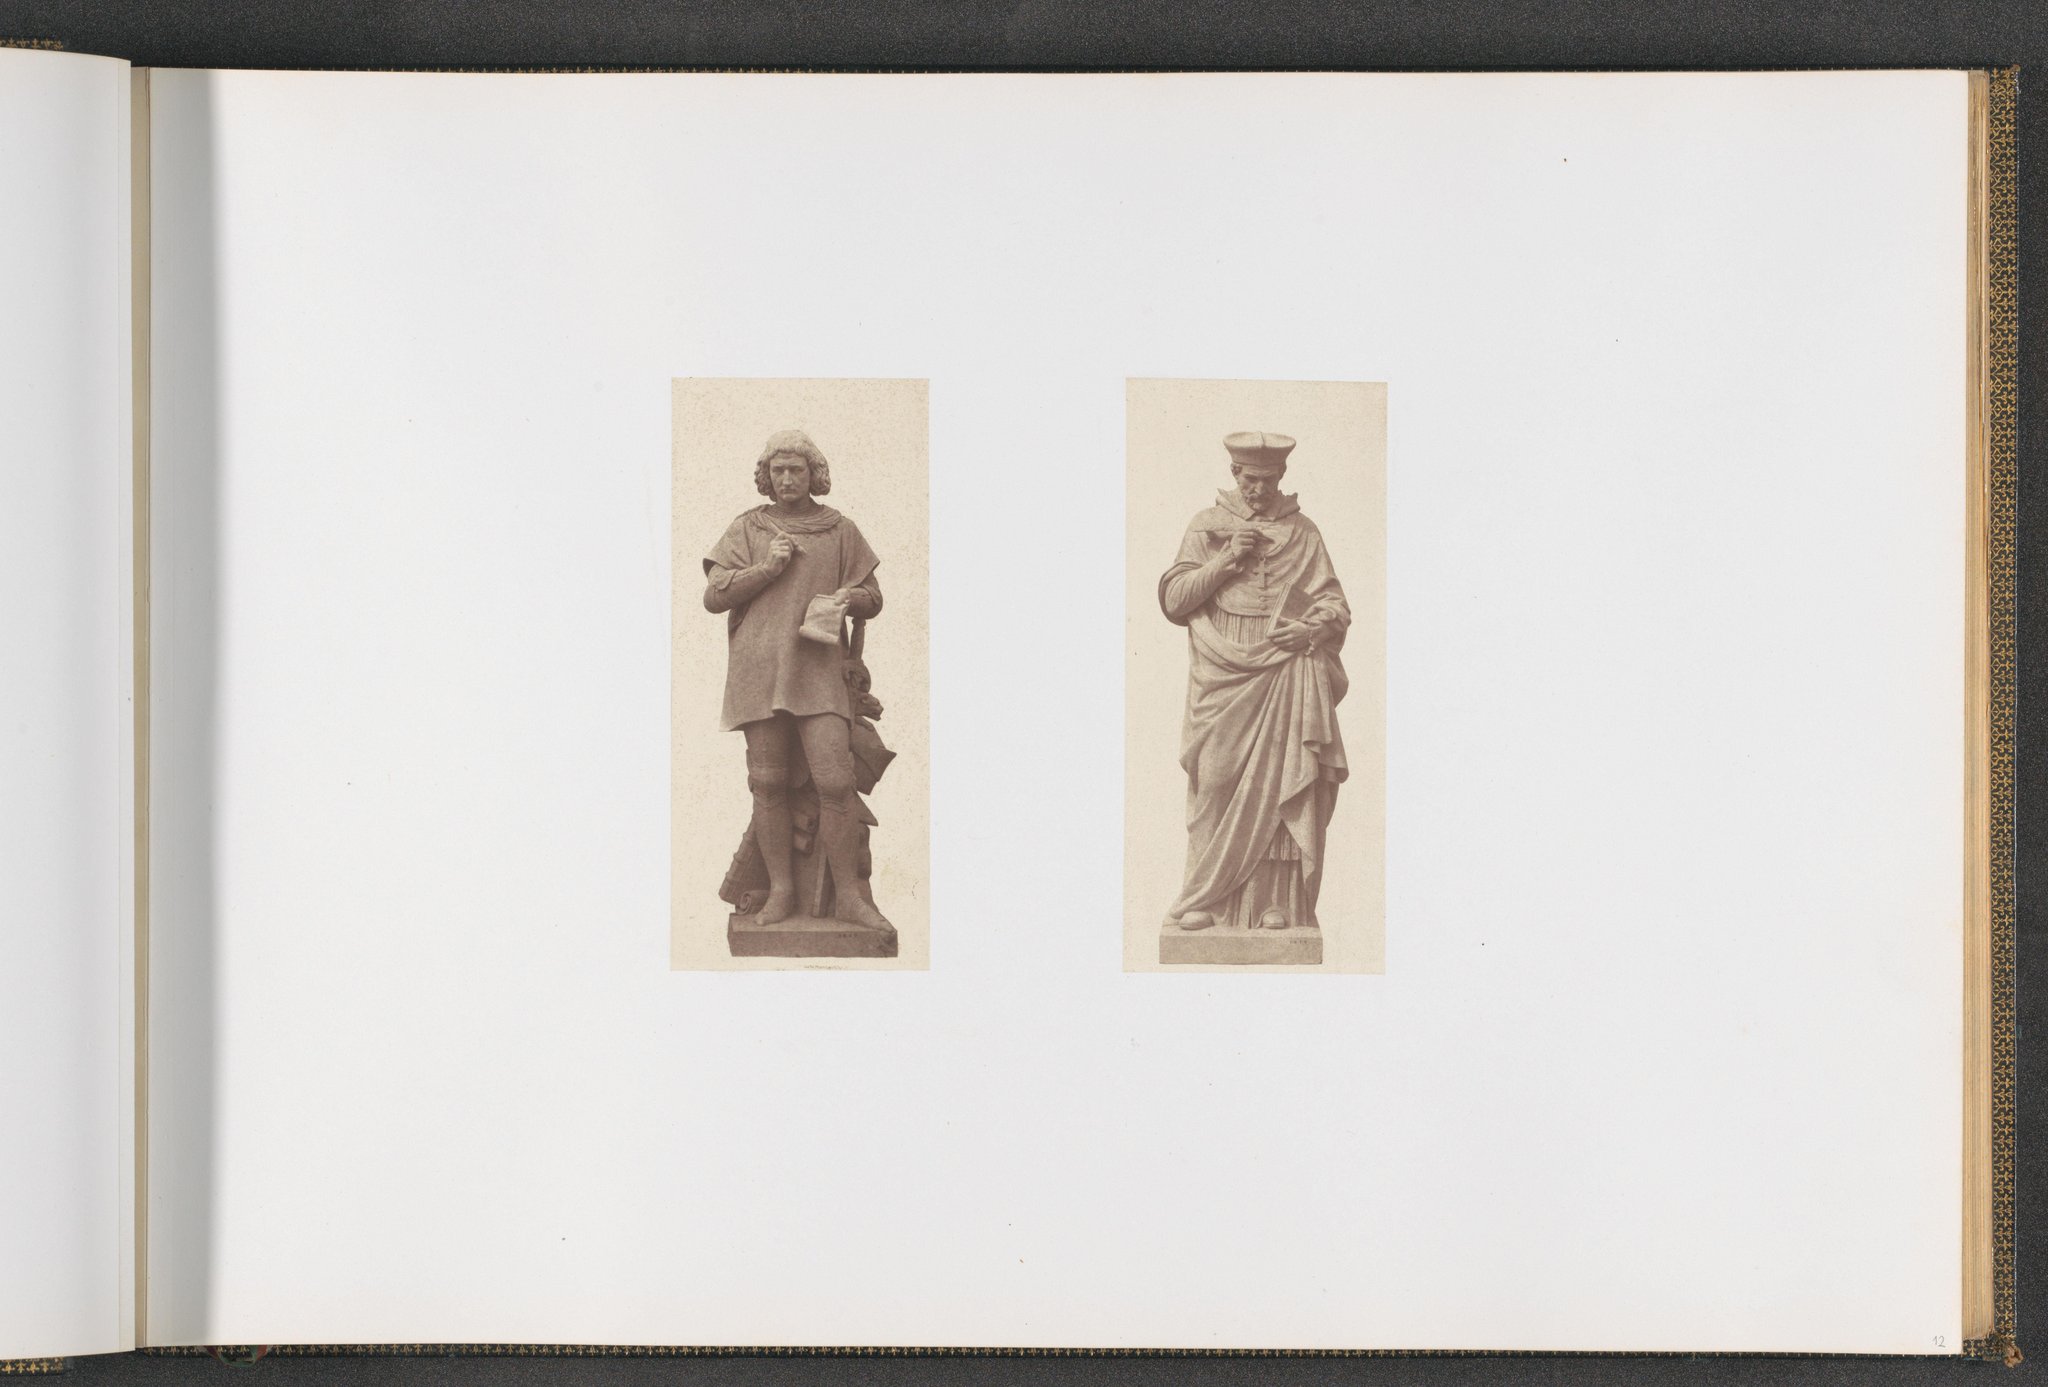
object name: photograph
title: Gipsmodellen voor beeldhouwwerken op het Palais du Louvre: links "Philippe de Commines" door Eugène Louis Lequesne en rechts "Amyot" door Pierre Travaux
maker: édouard denis baldus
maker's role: fotograaf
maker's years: 1813-1889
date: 1855-1857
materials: paper, photographic support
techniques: salted paper print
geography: paris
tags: piece of sculpture, reproduction of a piece of sculpture, permanent exhibition, museum, paris, tuileries palace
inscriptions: number: ‘1007 en 1010’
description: Onderdeel van Réunion des Tuileries au Louvre 1852-1857, album 2.